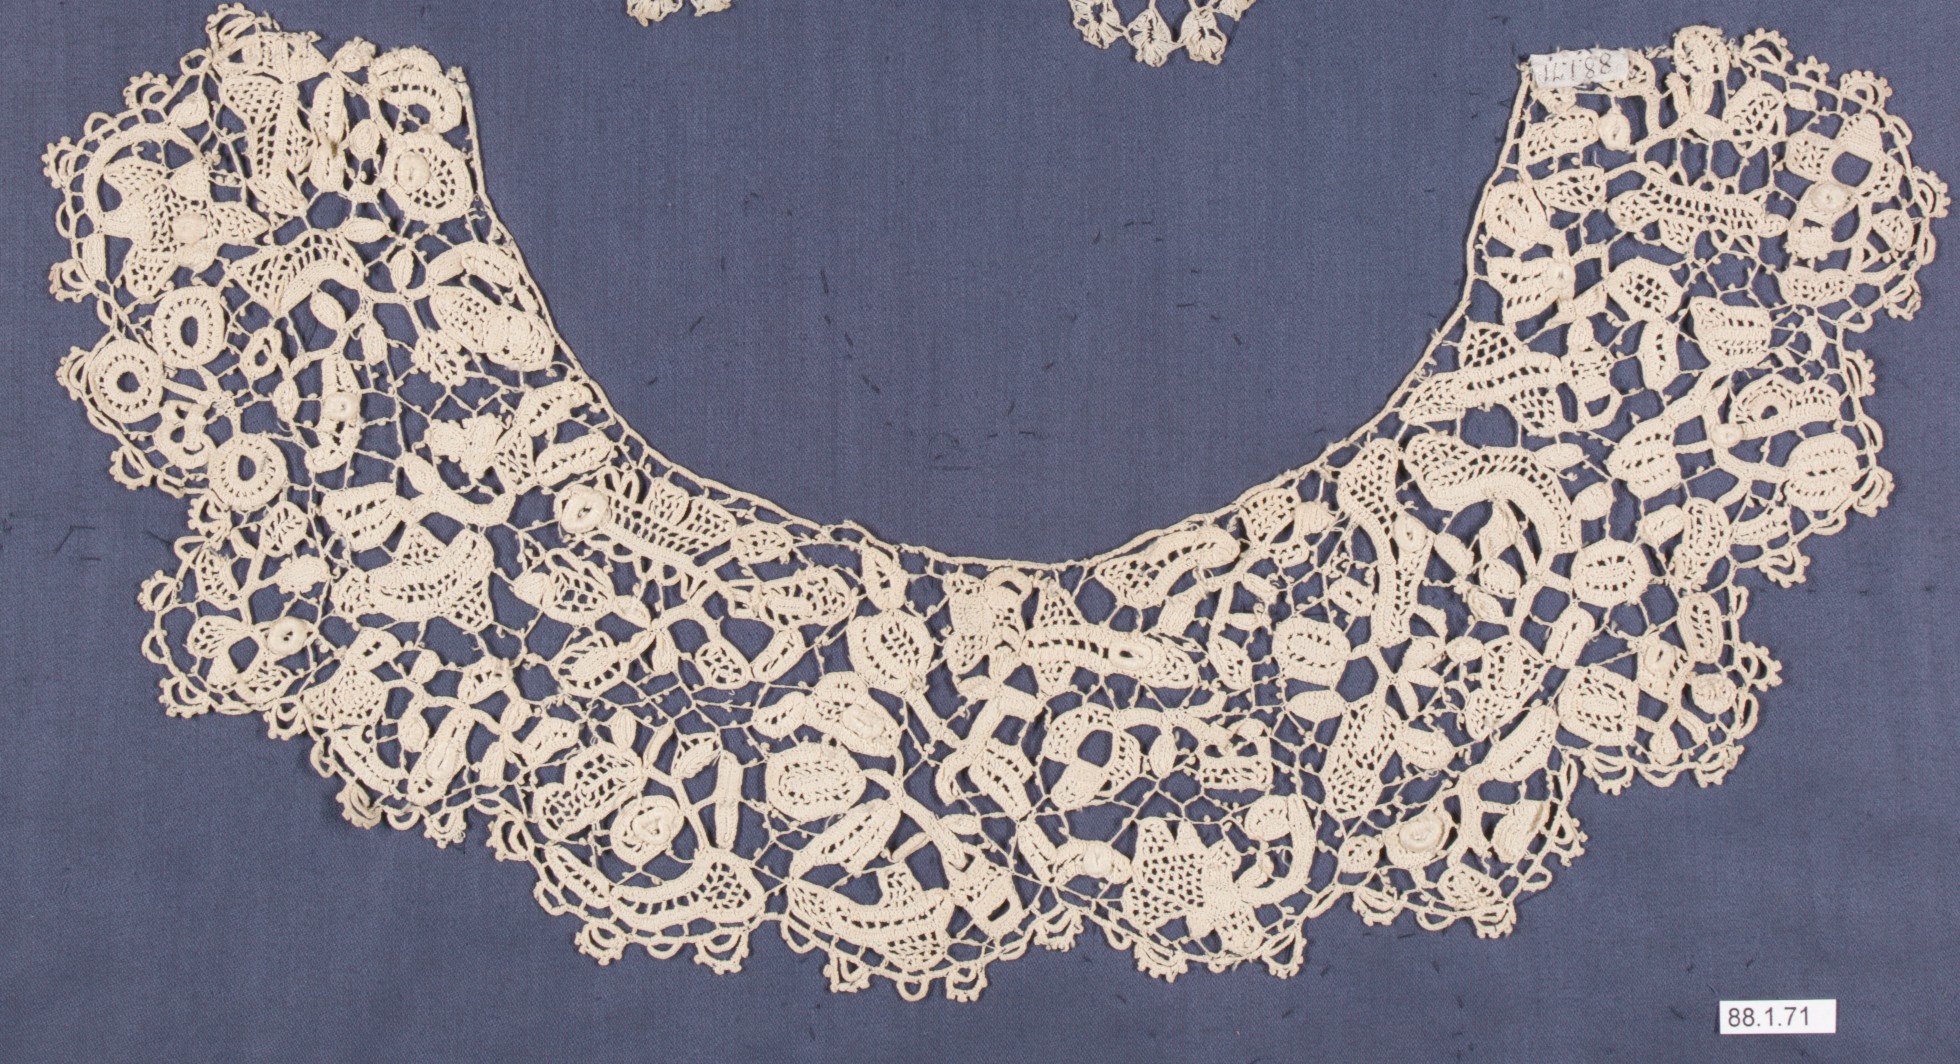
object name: collar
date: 1850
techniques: crochet